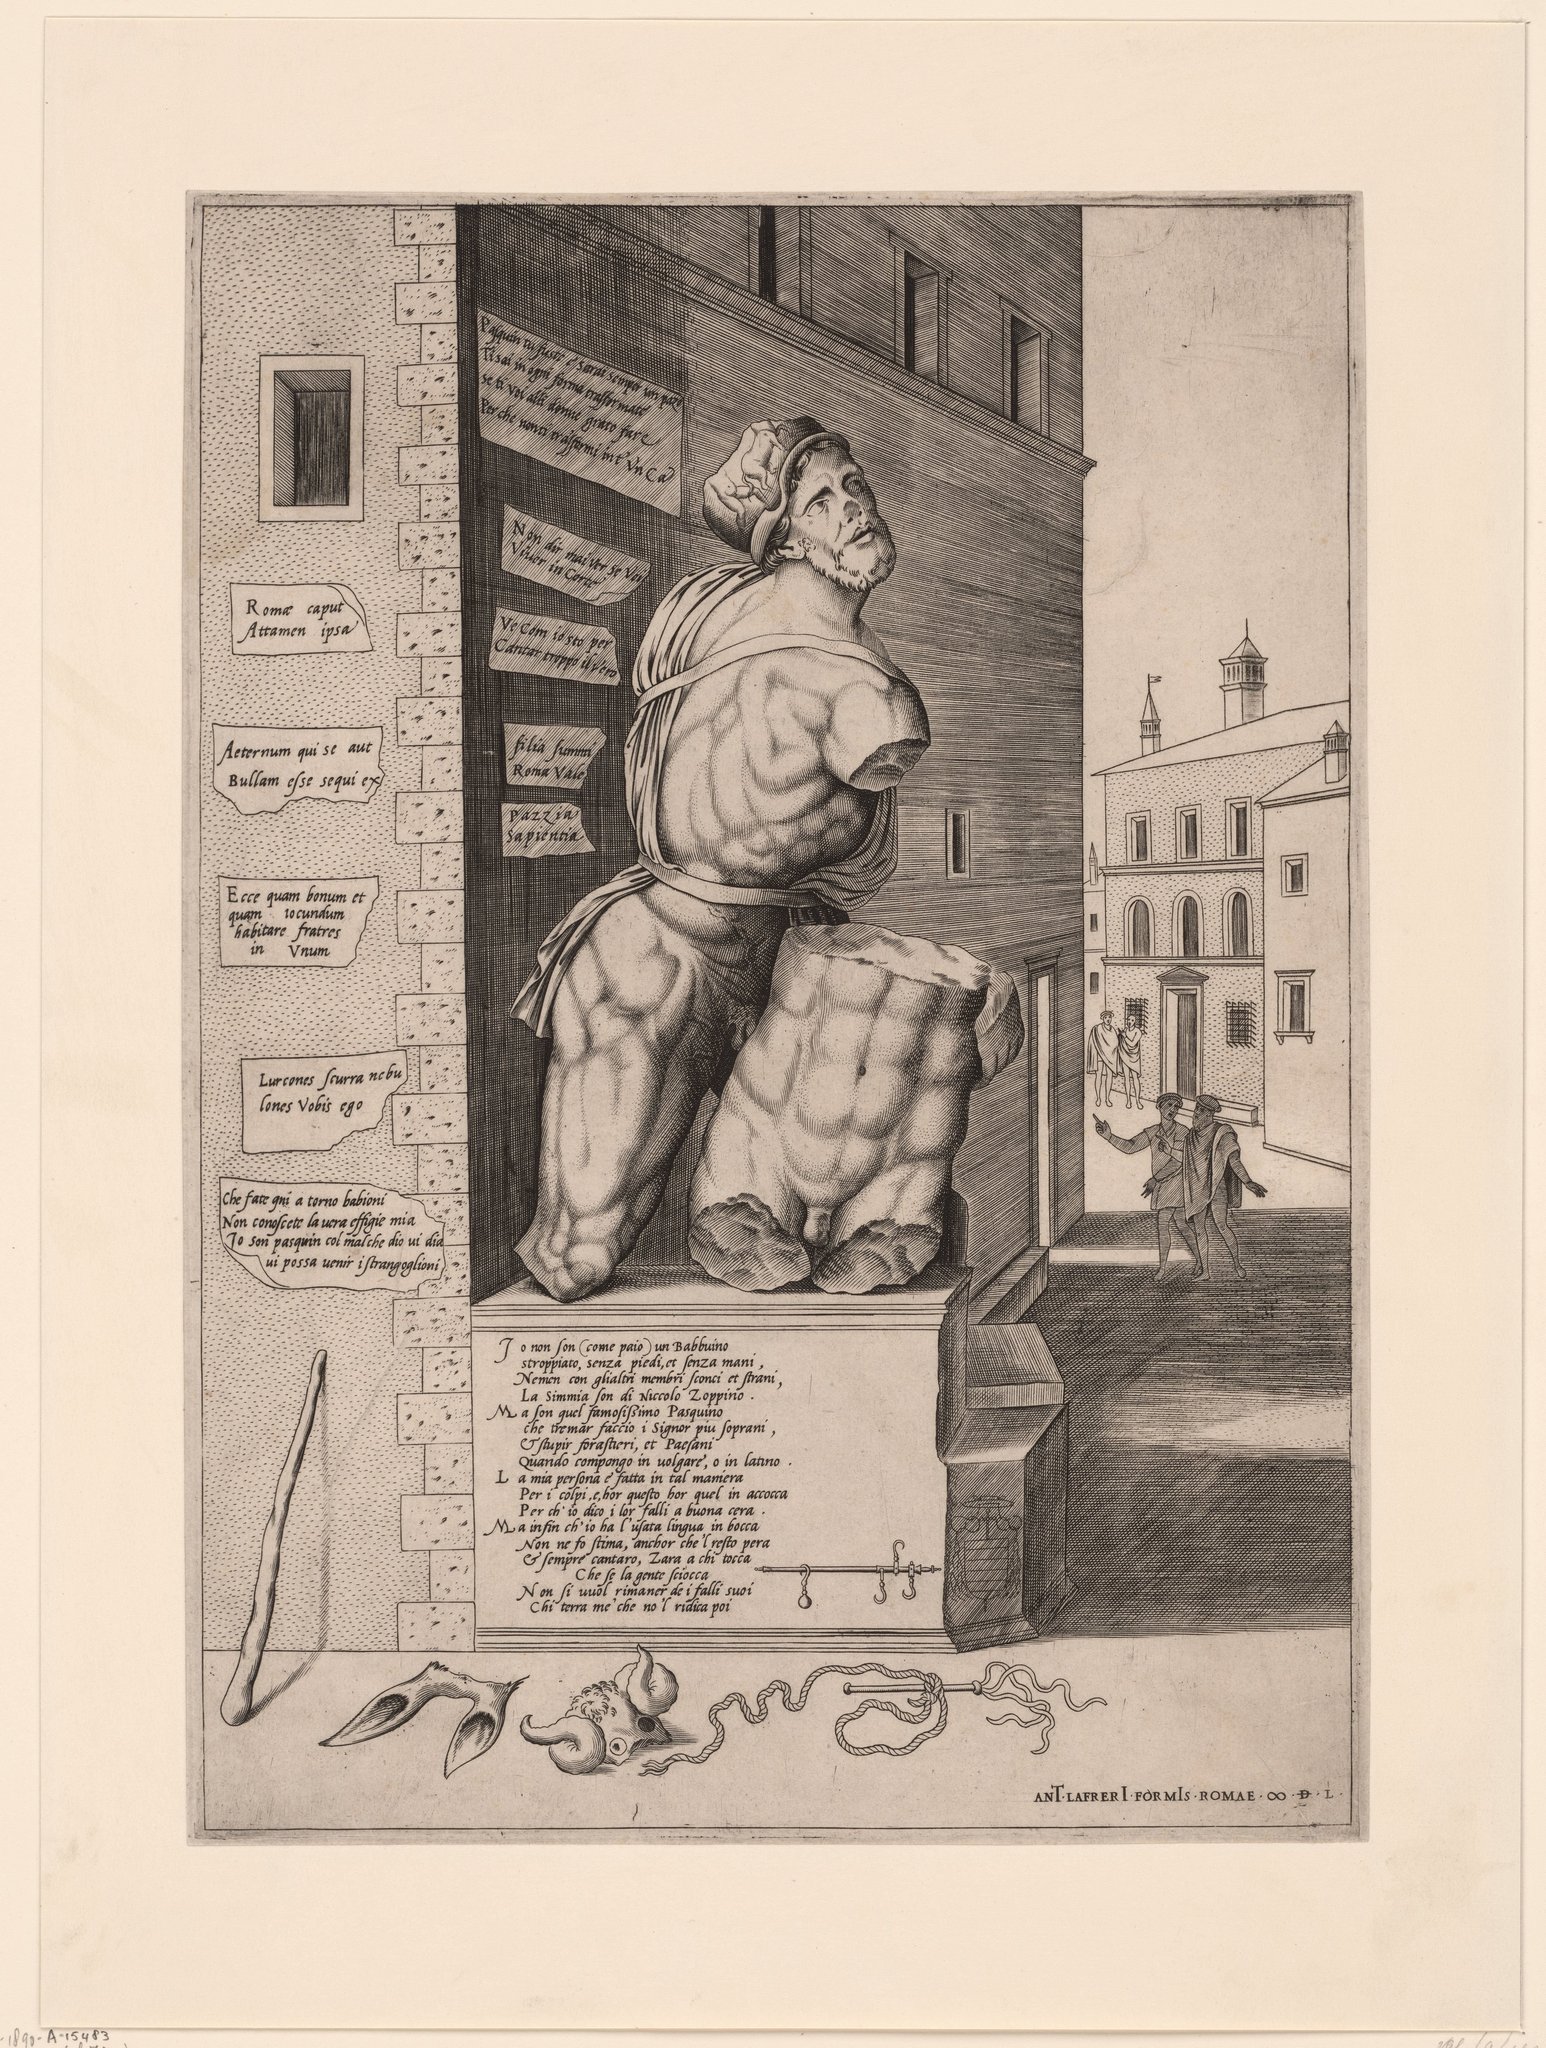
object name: print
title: Speculum Romanae Magnificentiae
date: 1550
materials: paper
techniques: engraving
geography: rome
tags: communication by means of 'statue parlanti', such as marforio and pasquino in rome, piece of sculpture, reproduction of a piece of sculpture, rome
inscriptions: collector's mark: Lugt 2228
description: Het beeld staat op het Piazza di Pasquino in Rome. Deze prent behoort tot het prentcorpus dat bekend staat als de ‘Speculum Romanae Magnificentiae’ (‘Spiegel van Romeinse pracht’). Dit corpus, bestaande uit prenten met voorstellingen van kunstwerken en gebouwen uit het antieke en het moderne Rome, vond zijn oorsprong bij uitgevers Antonio Salamanca en Antonio Lafreri. Deze twee buitenlandse uitgevers bundelden hun krachten te Rome in de periode 1553-1563. Hun prenten werden al snel razend populair bij toeristen en verzamelaars, die de prenten individueel of in grote groepen aanschaften. Grote groepen Speculum-prenten werden vaak op aanvraag samengebonden in albums. Er zijn verschillende Speculum-albums overgeleverd die allemaal verschillen van inhoud. Tussen 1573 en 1577 gaf Antonio Lafreri een speciale titelpagina uit (met de titel ‘Speculum Romanae Magnificentiae’) die mensen voor hun verzamelingen konden voegen. Het overlijden van Lafreri in 1577 betekende niet het einde van het corpus. Een groot deel van de koperplaten ging over op Claudio en Stefano Duchetti. De rest raakte verspreid over verschillende andere uitgevers. De populariteit van de Speculum-prenten wist nog geruime periode uitgevers te inspireren tot het laten maken van kopieën en het toevoegen van nieuwe prenten aan het corpus.